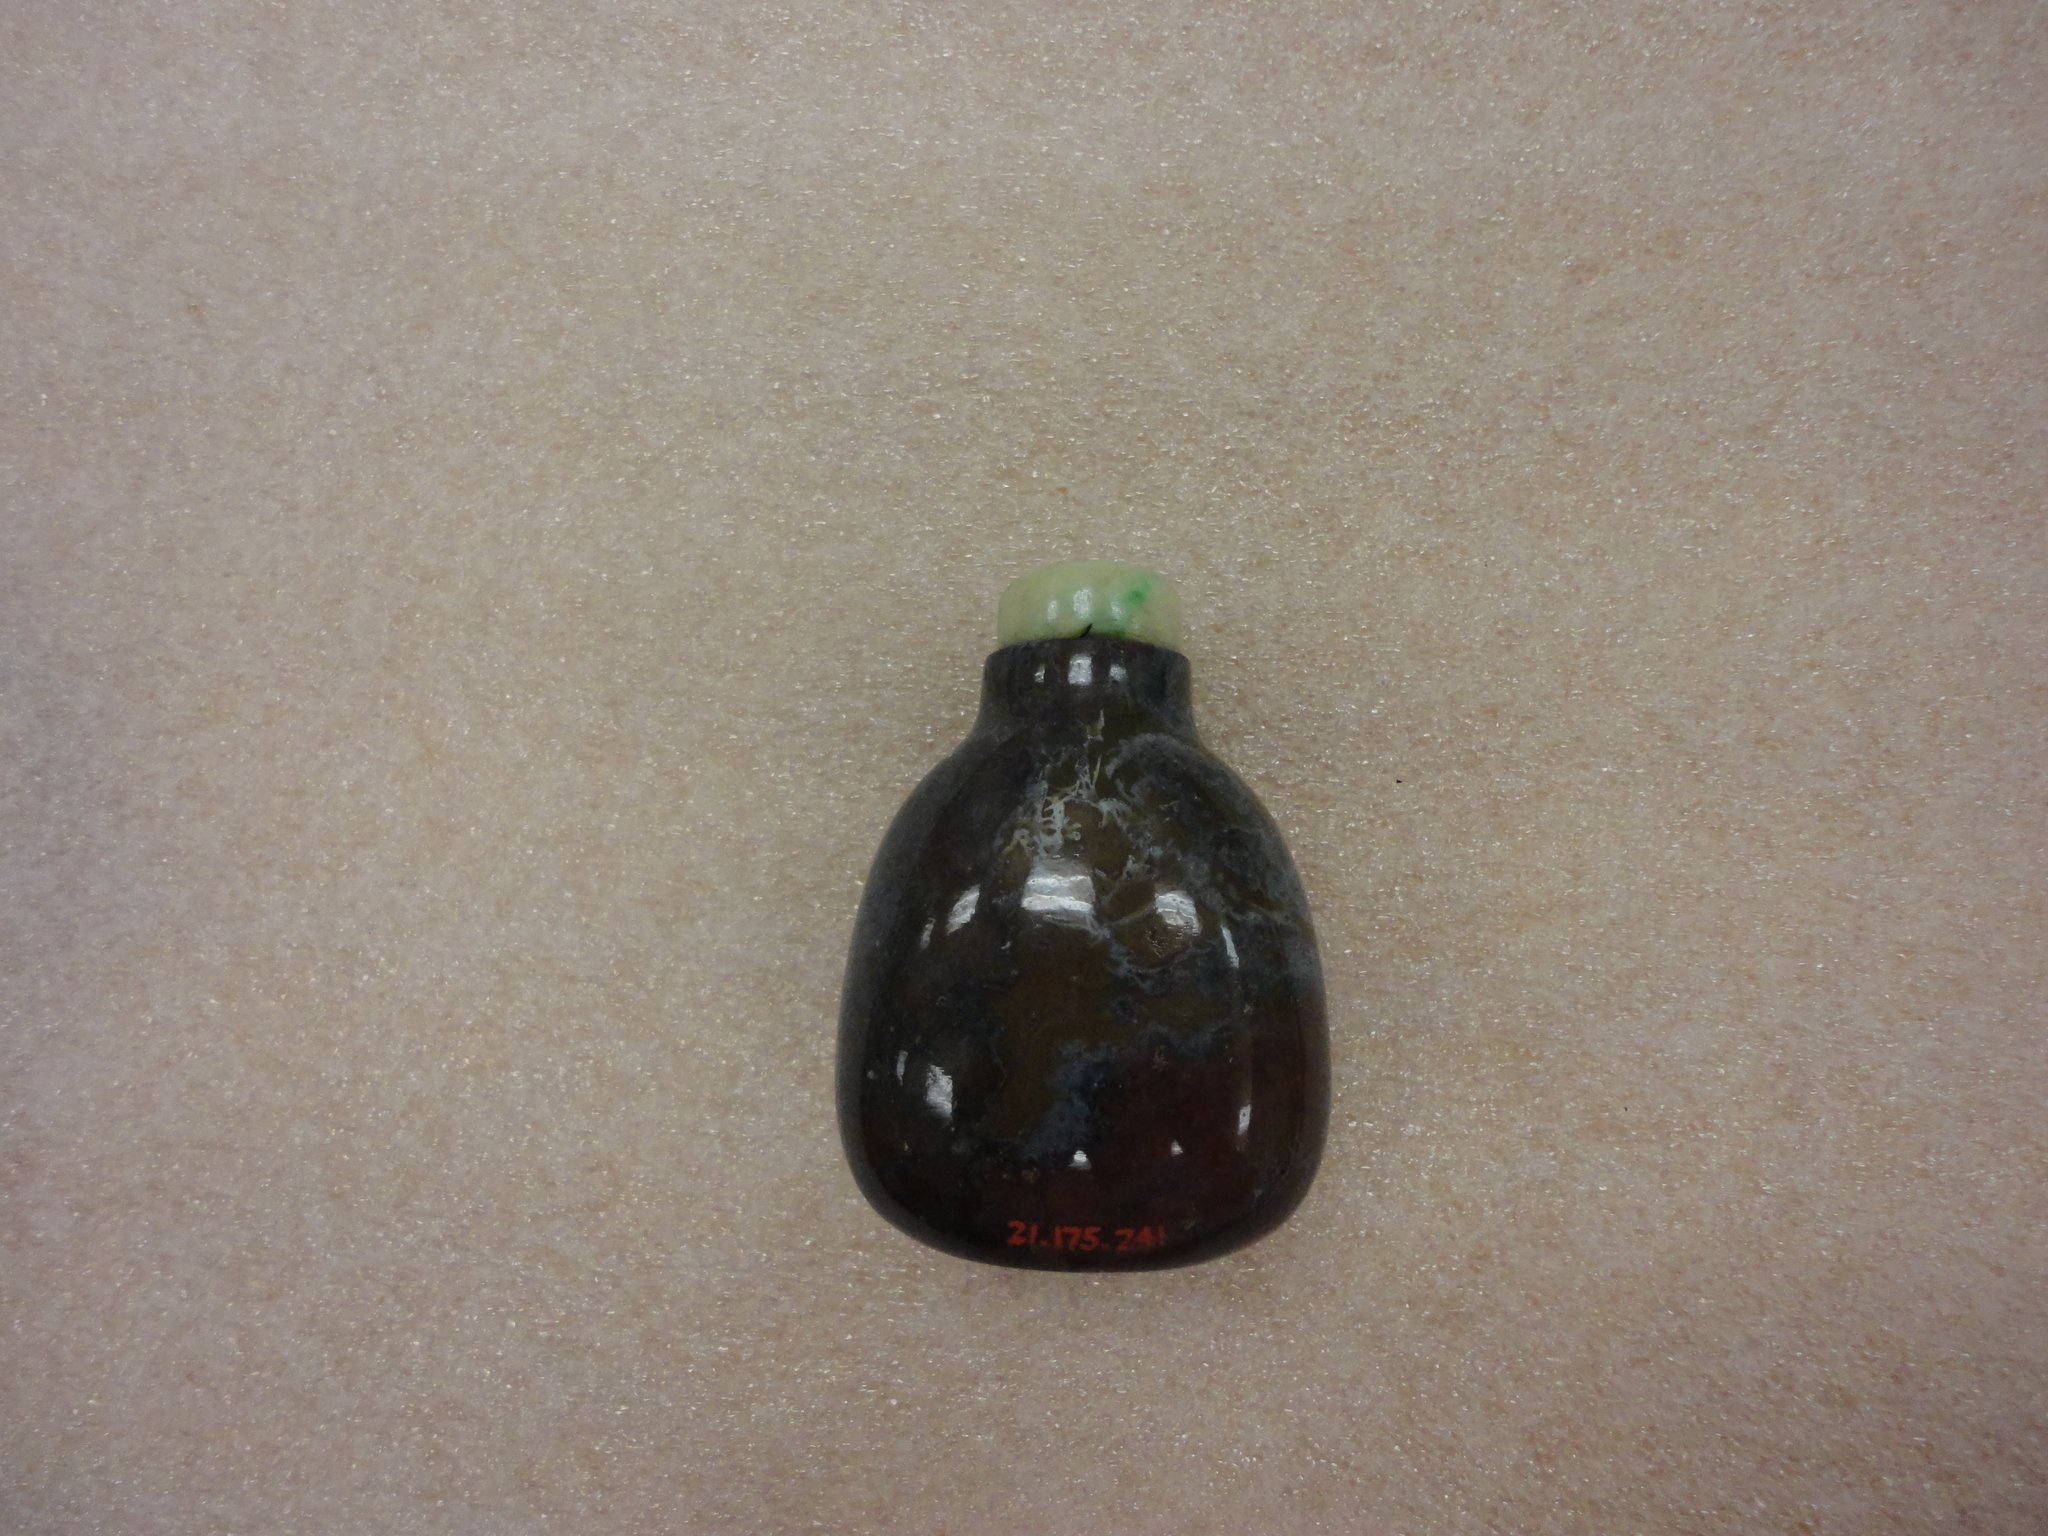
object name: snuff bottle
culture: chinese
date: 1736-1795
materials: stone, jade